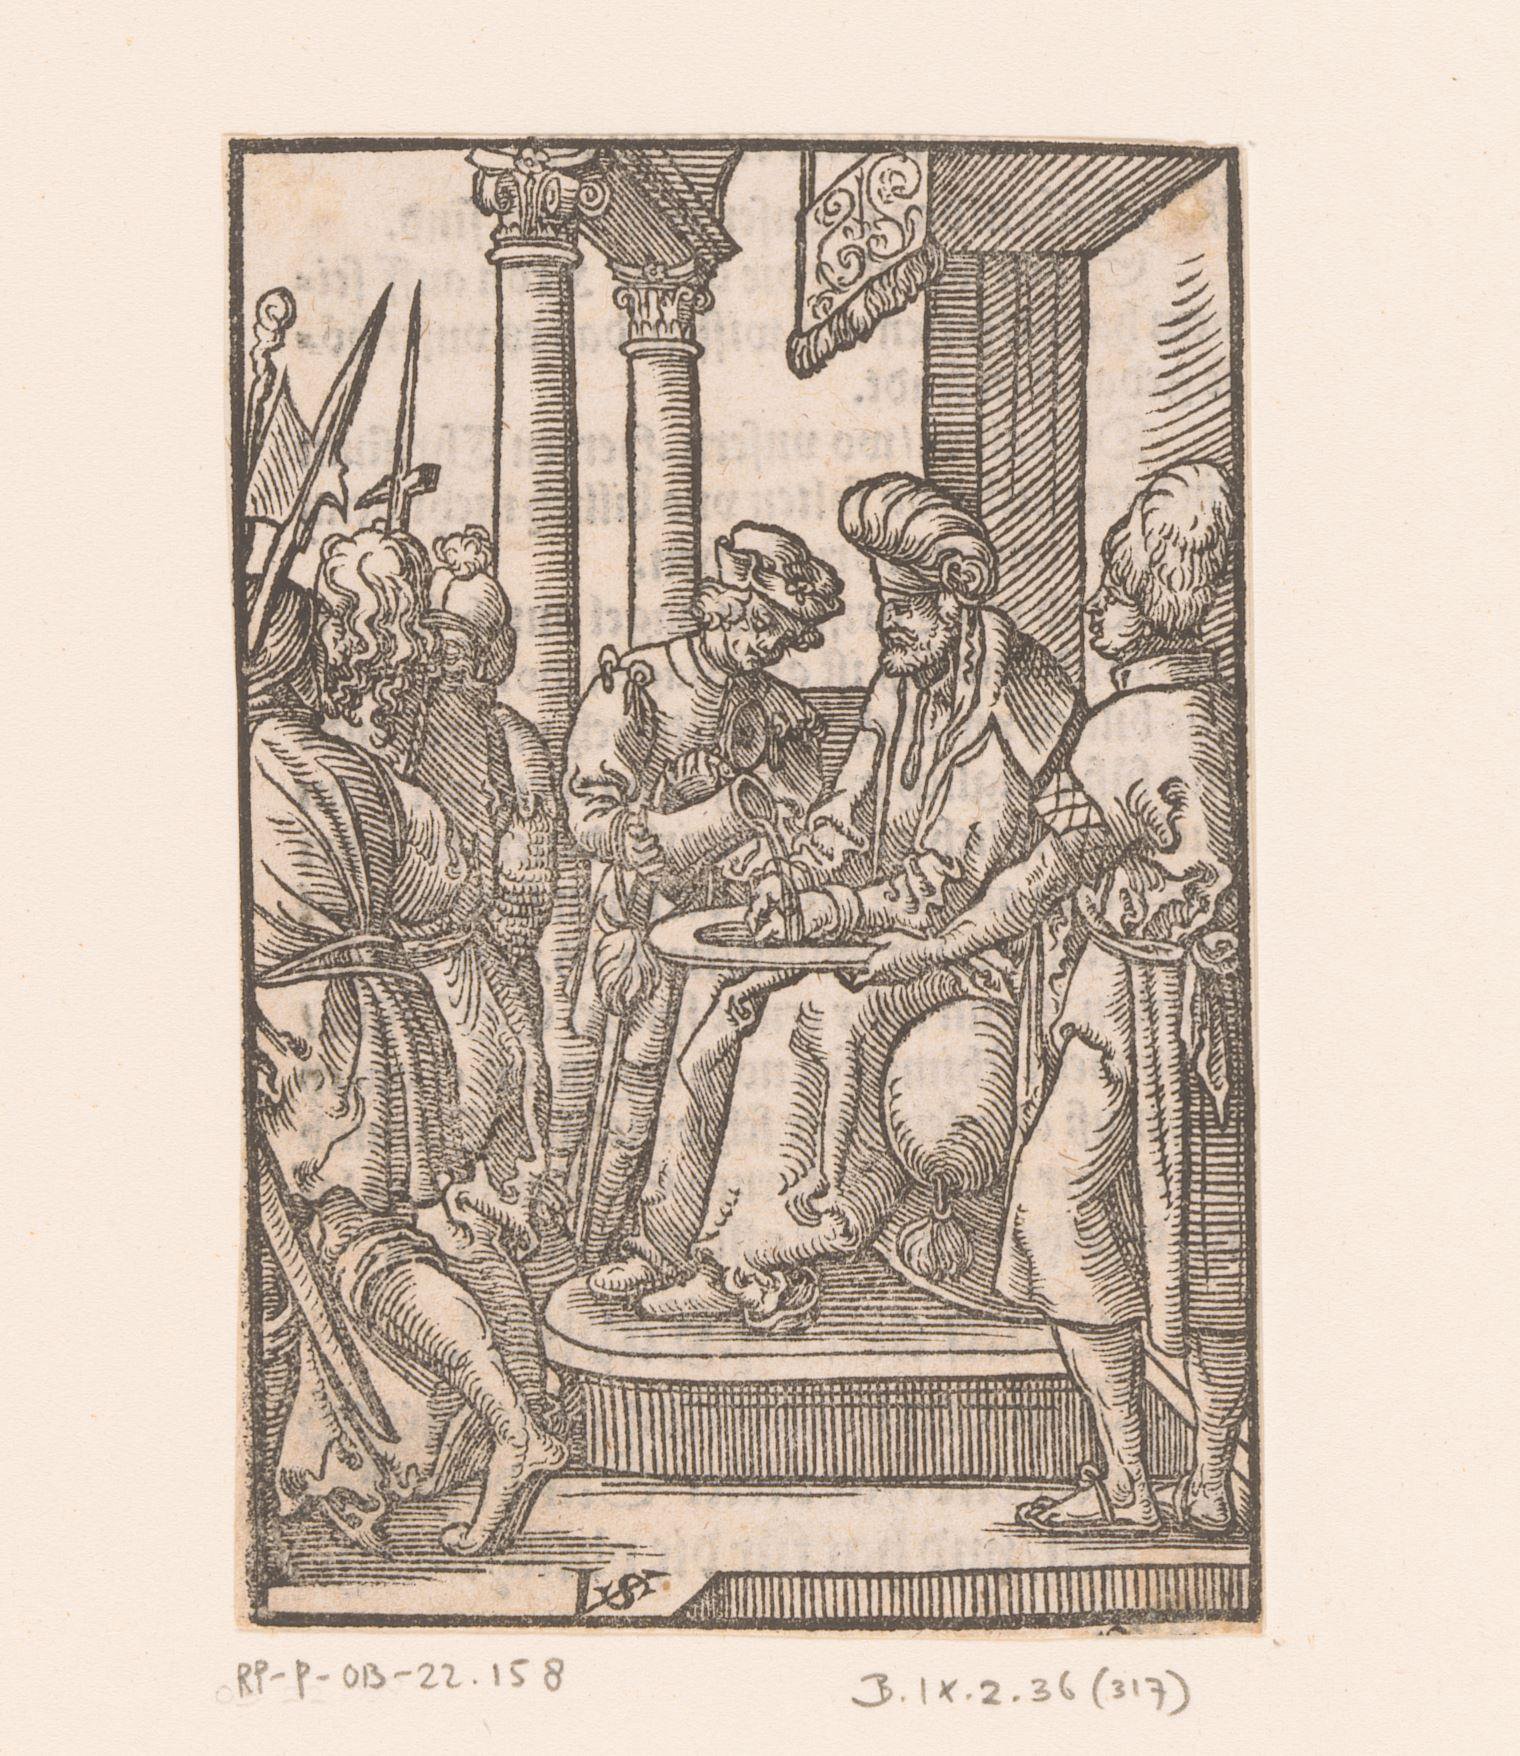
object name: print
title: Pilatus wast zijn handen in onschuld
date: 1552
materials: paper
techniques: woodcut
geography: nuremberg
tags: pilate washing his hands (in innocence)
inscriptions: number: ‘181’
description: Gebruikt voor verschillende publicaties die werden gedrukt door Valentin Geißler tussen 1552 en 1560 te Neurenberg.